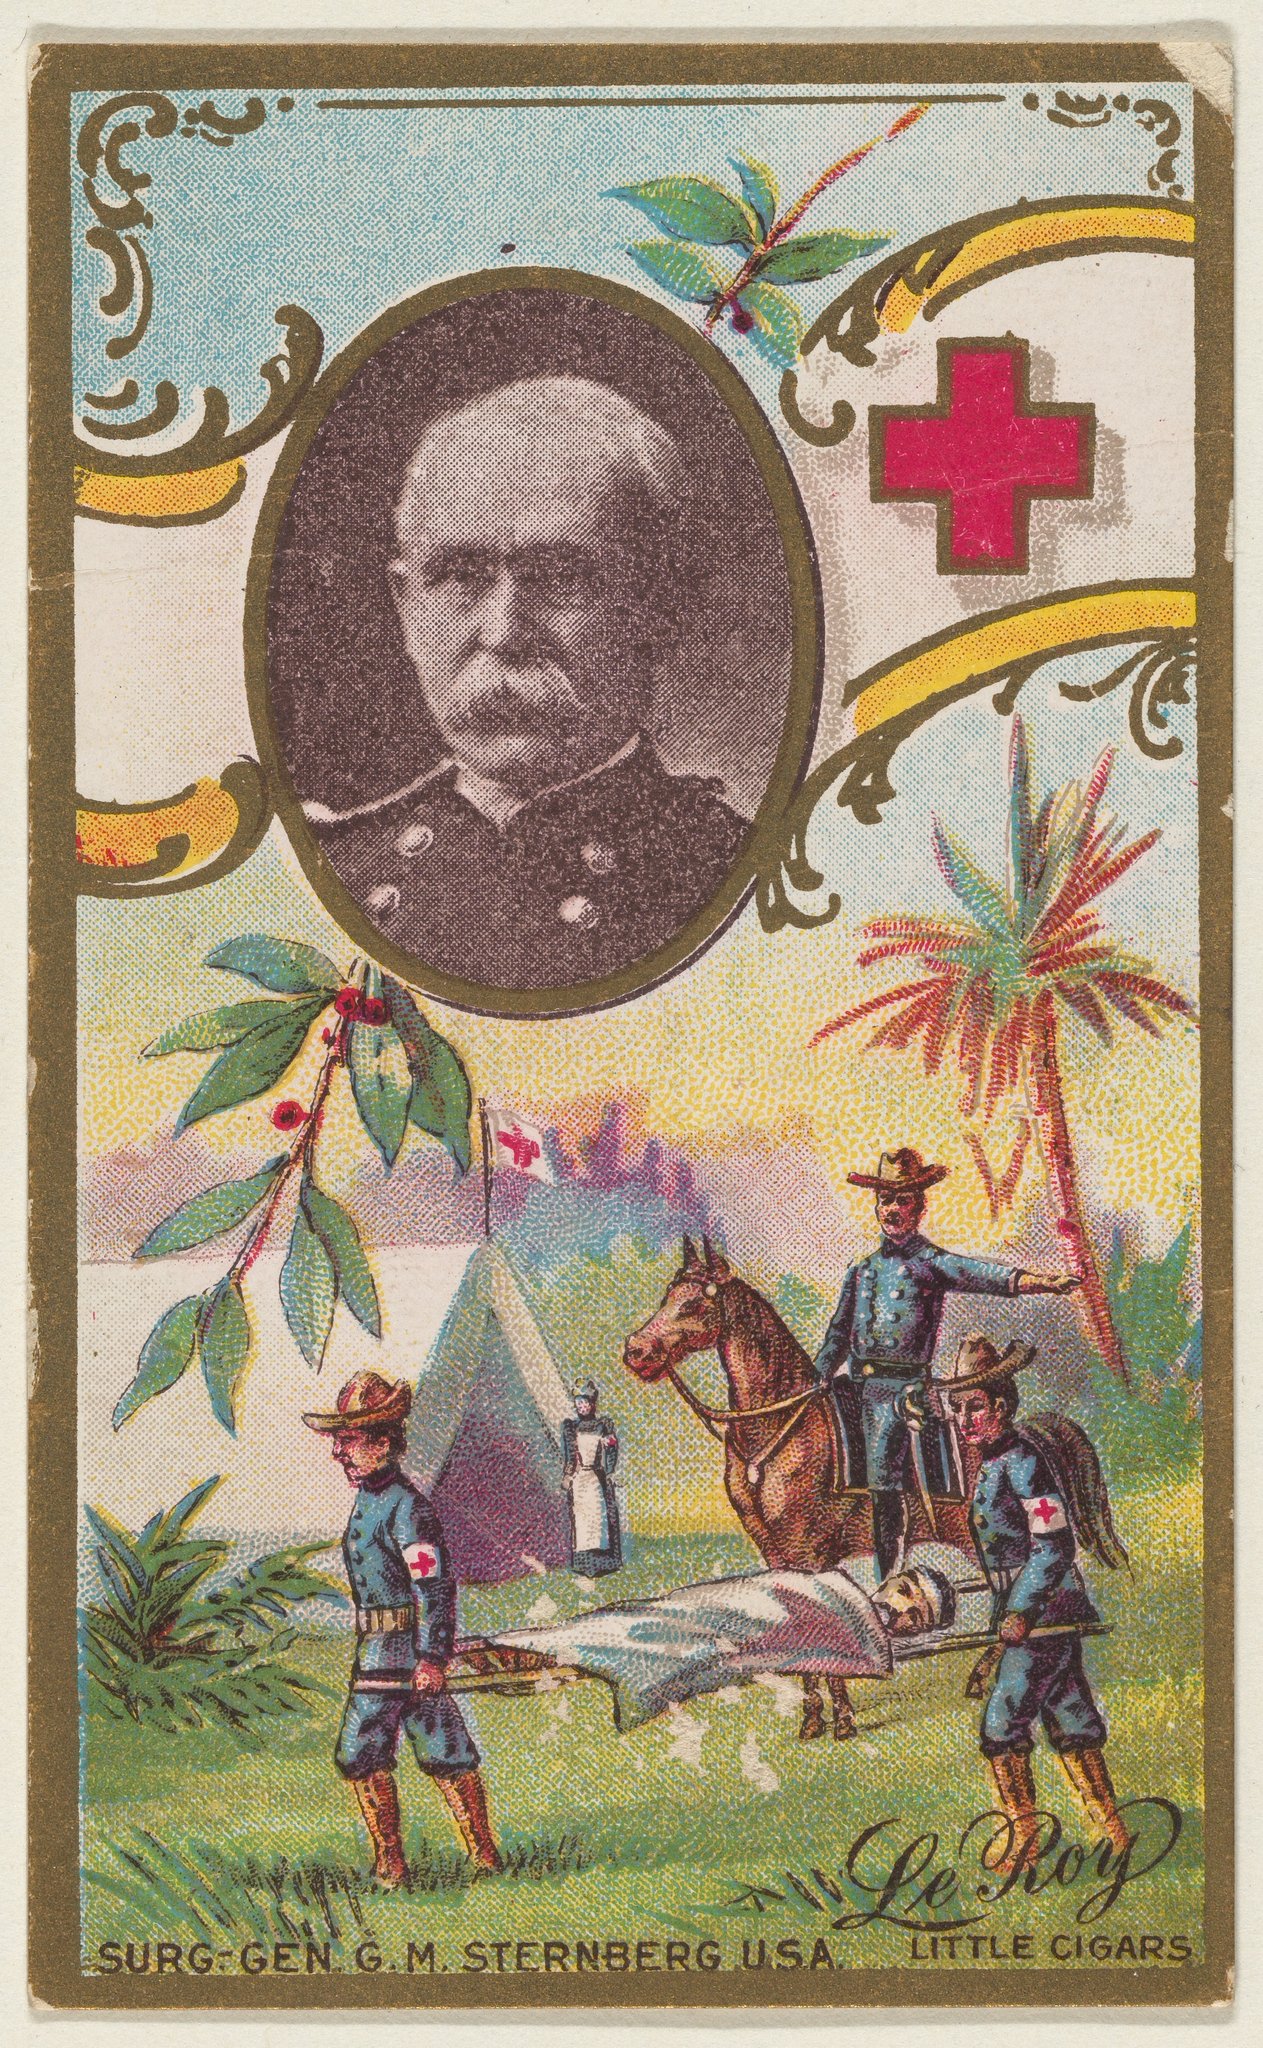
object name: print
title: Surgeon General George M. Sternberg, U.S. Army, from the "Generals" series (T63), issued by LeRoy Little Cigars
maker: leroy little cigars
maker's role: publisher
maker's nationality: american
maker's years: 1850-1950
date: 1898-1901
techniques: color lithograph